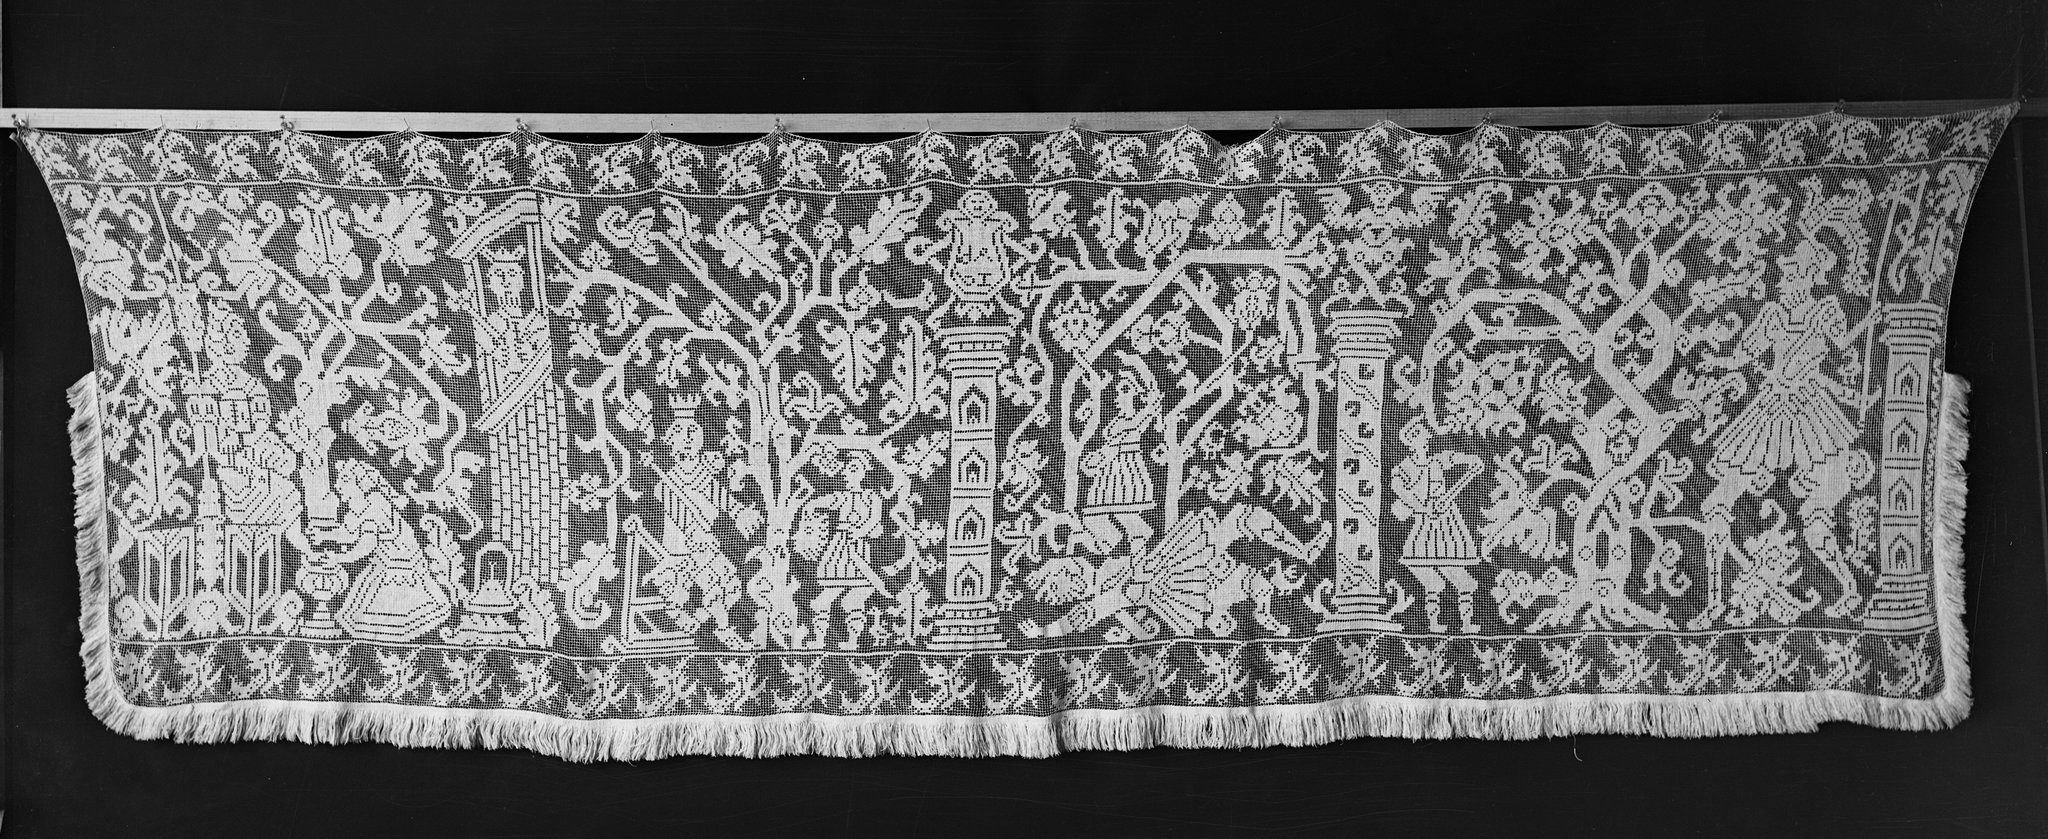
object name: altar frontal valance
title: Valance of an altar frontal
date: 1601-1700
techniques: embroidery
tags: human figures